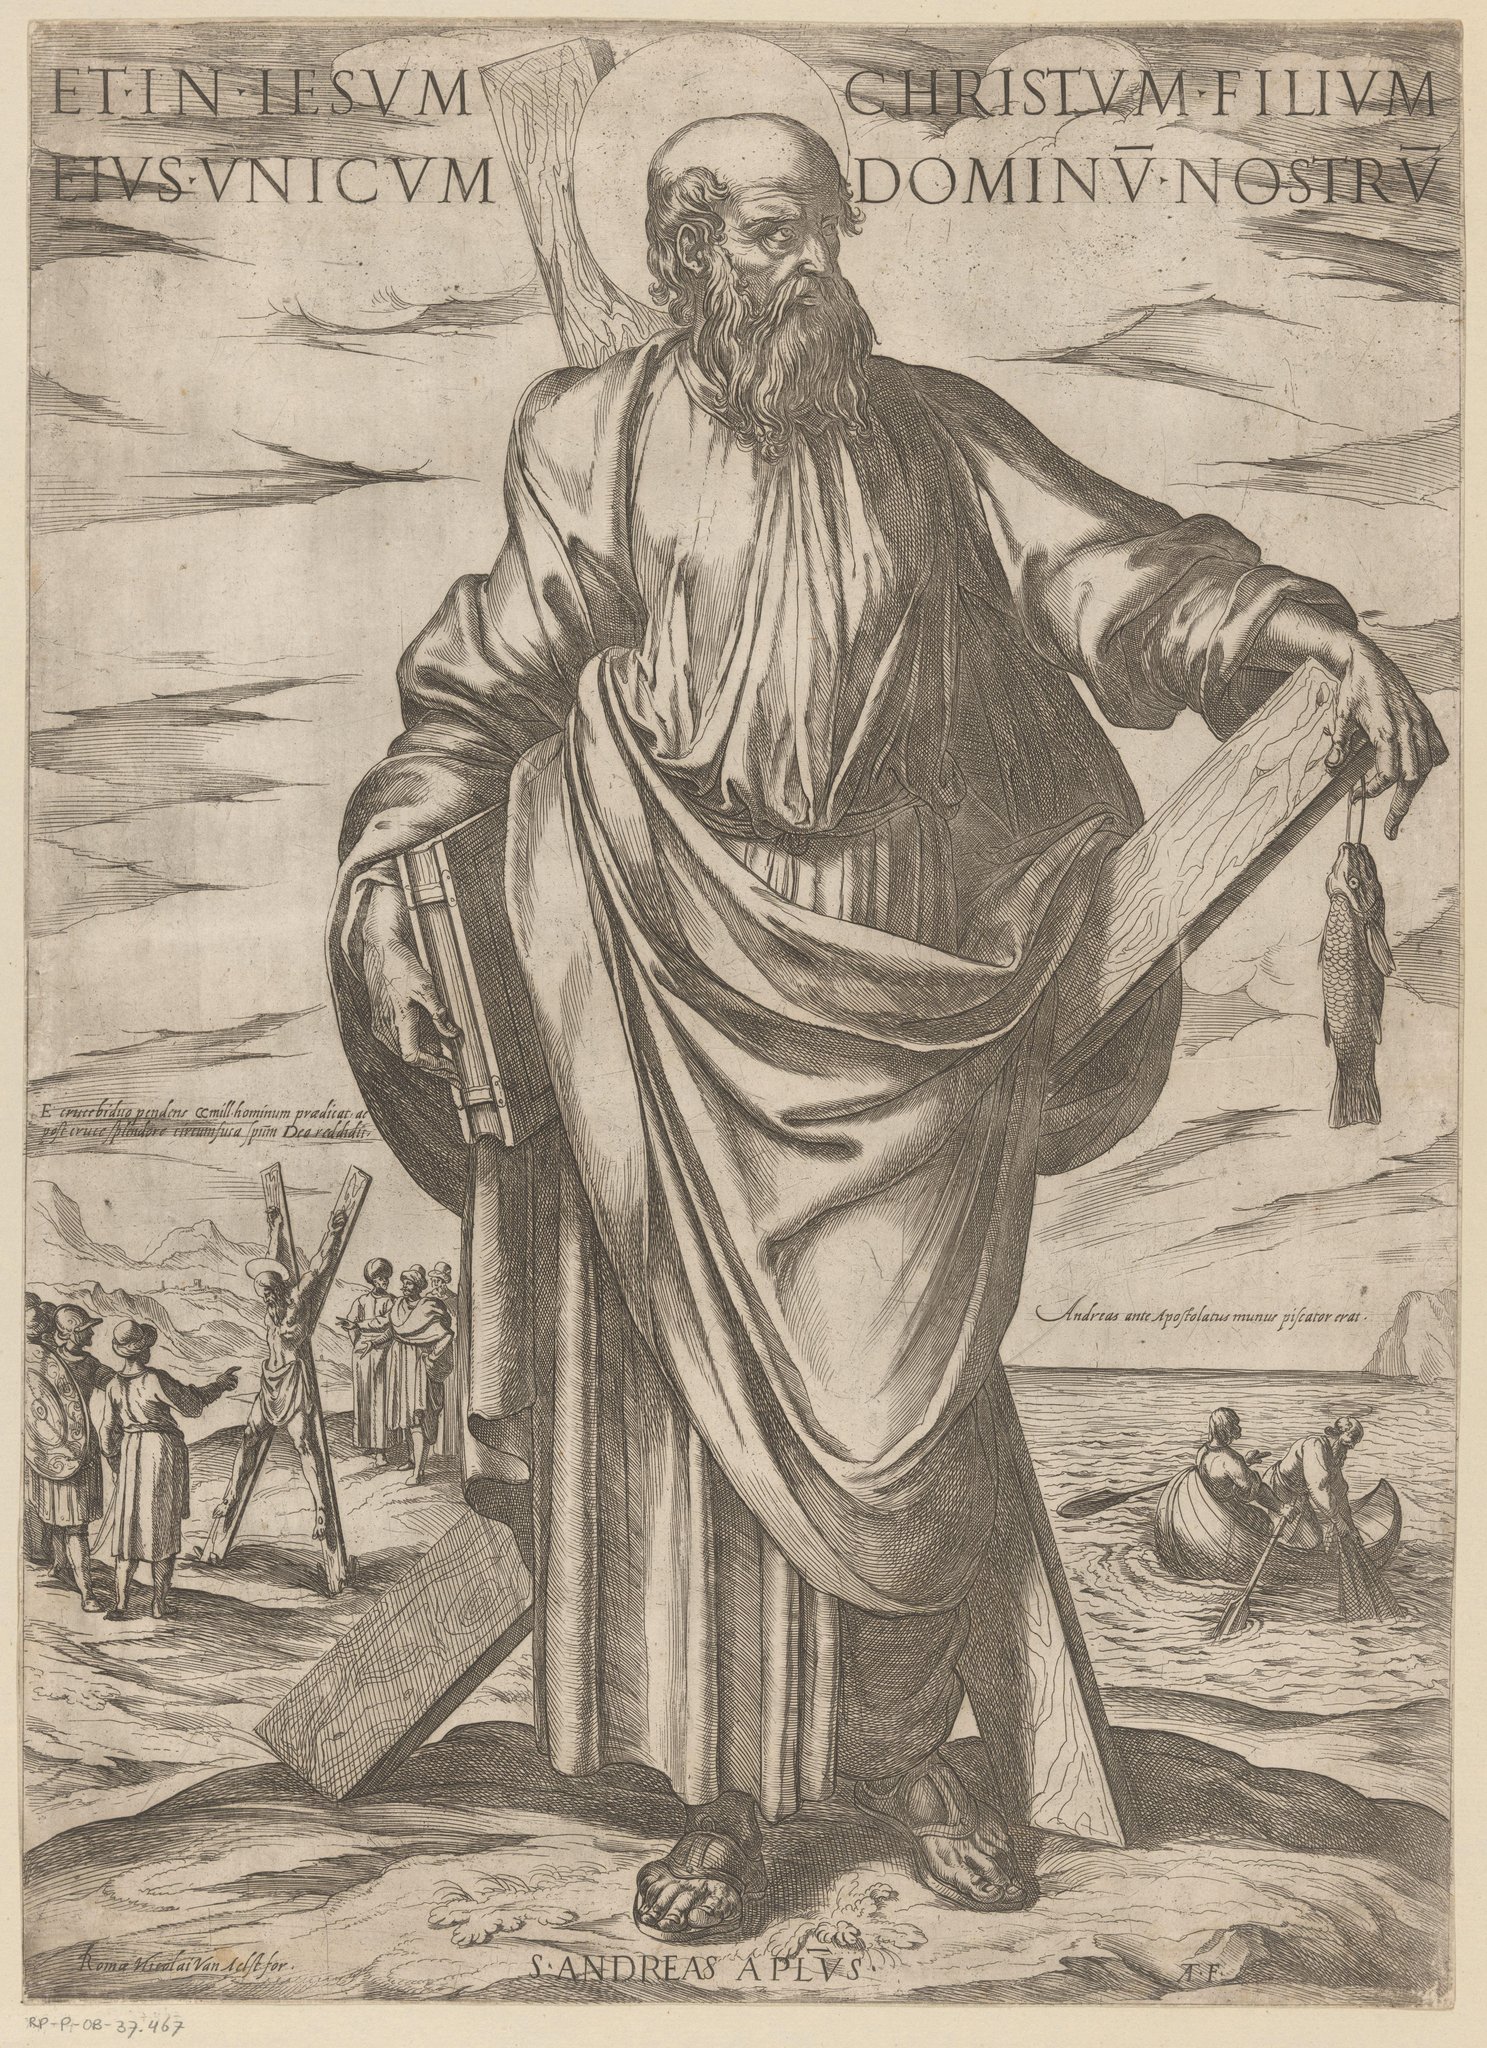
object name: print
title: Christus, Maria en de apostelen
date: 1565-1630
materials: paper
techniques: etching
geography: rome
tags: the apostle andrew; possible attributes: book, x-shaped cross, fish, fishing-net, rope, scroll, crucifixion of andrew: he is undressed and tied to the cross, calling of peter and andrew; they are called away from their fishing-boat (matthew 4:18-20; mark 1:16-18)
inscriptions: collector's mark: Lugt 240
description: De heilige Andreas met boek, vis en Andreaskruis. Op de achtergrond rechts de heilige Andreas vissend in een boot op zee. Op de achtergrond links de kruisiging van de heilige Andreas.